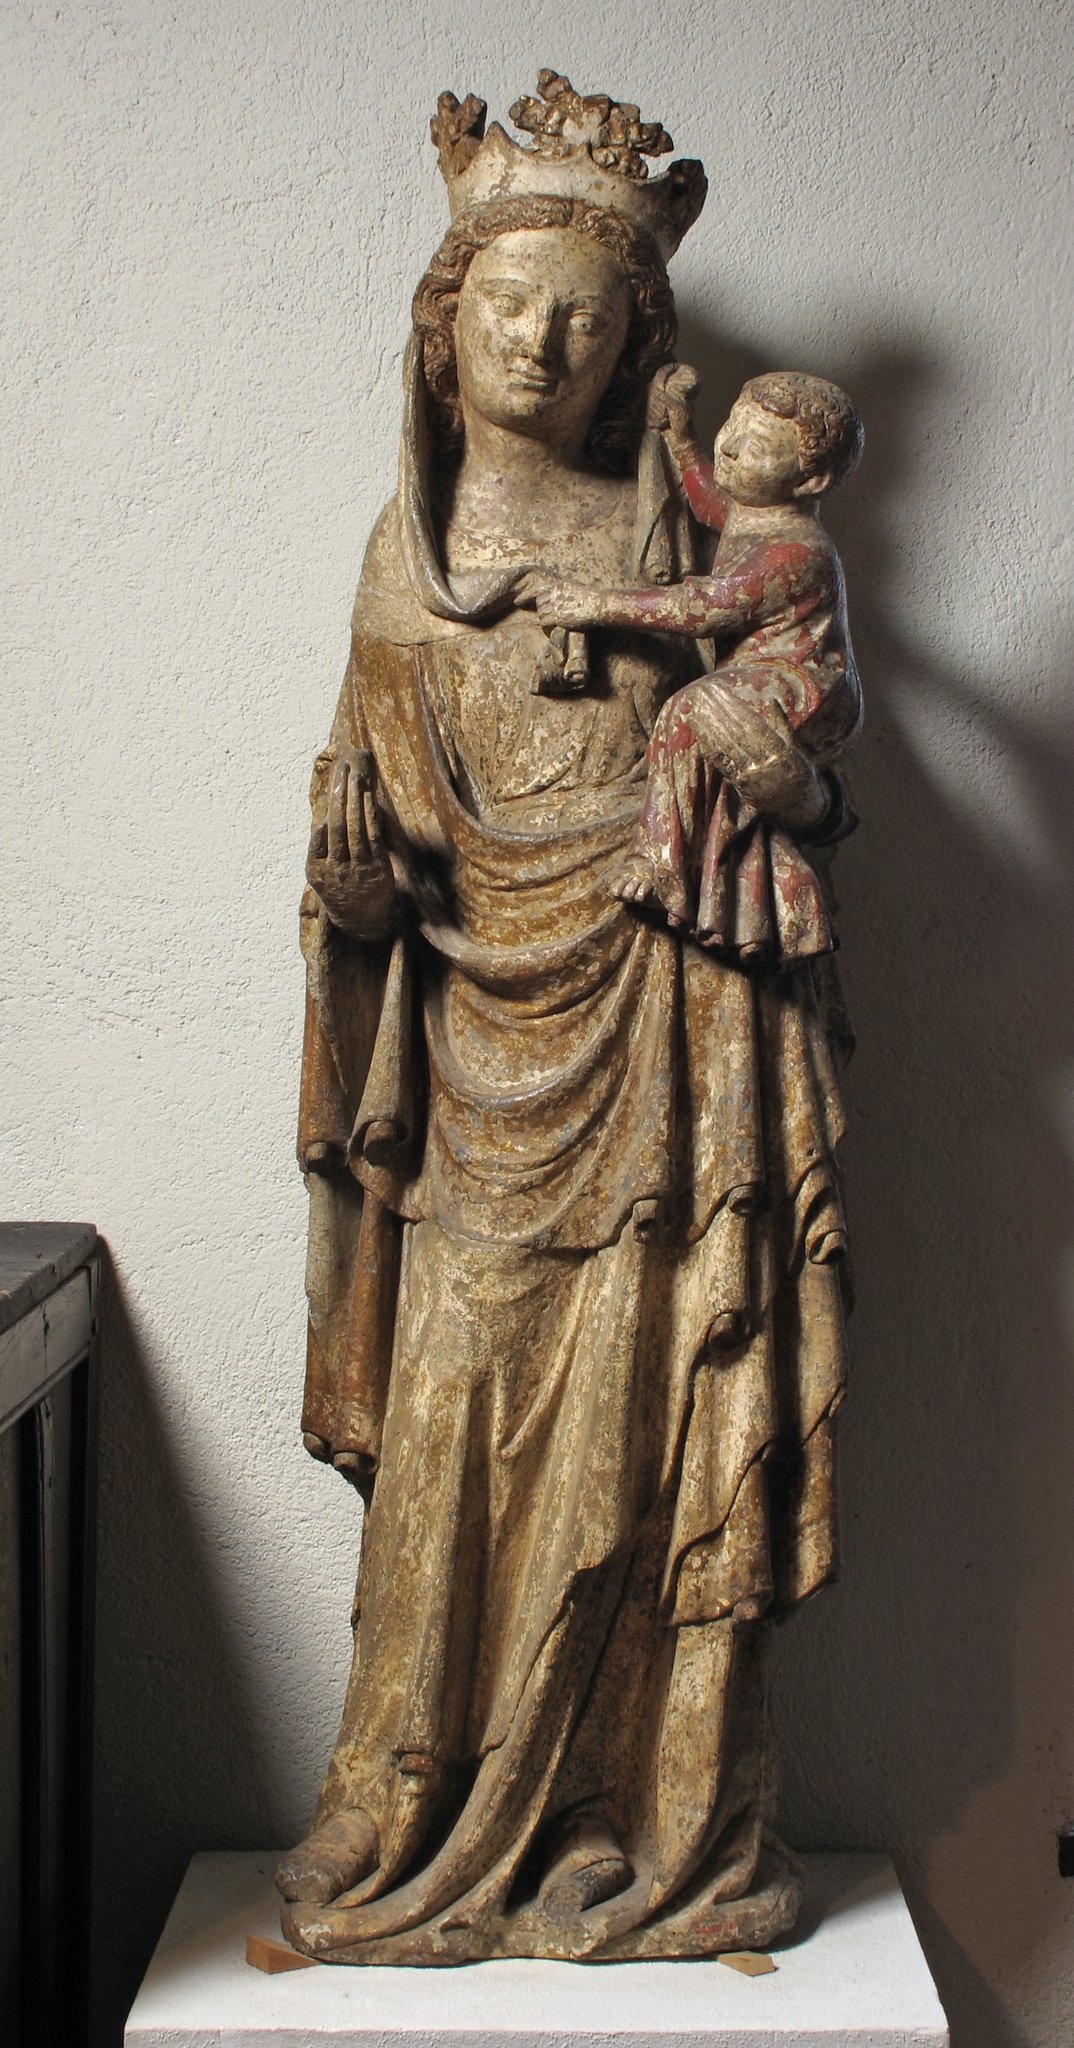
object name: statue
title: Virgin and Child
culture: french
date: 1301-1400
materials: stone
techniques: gilding, polychrome